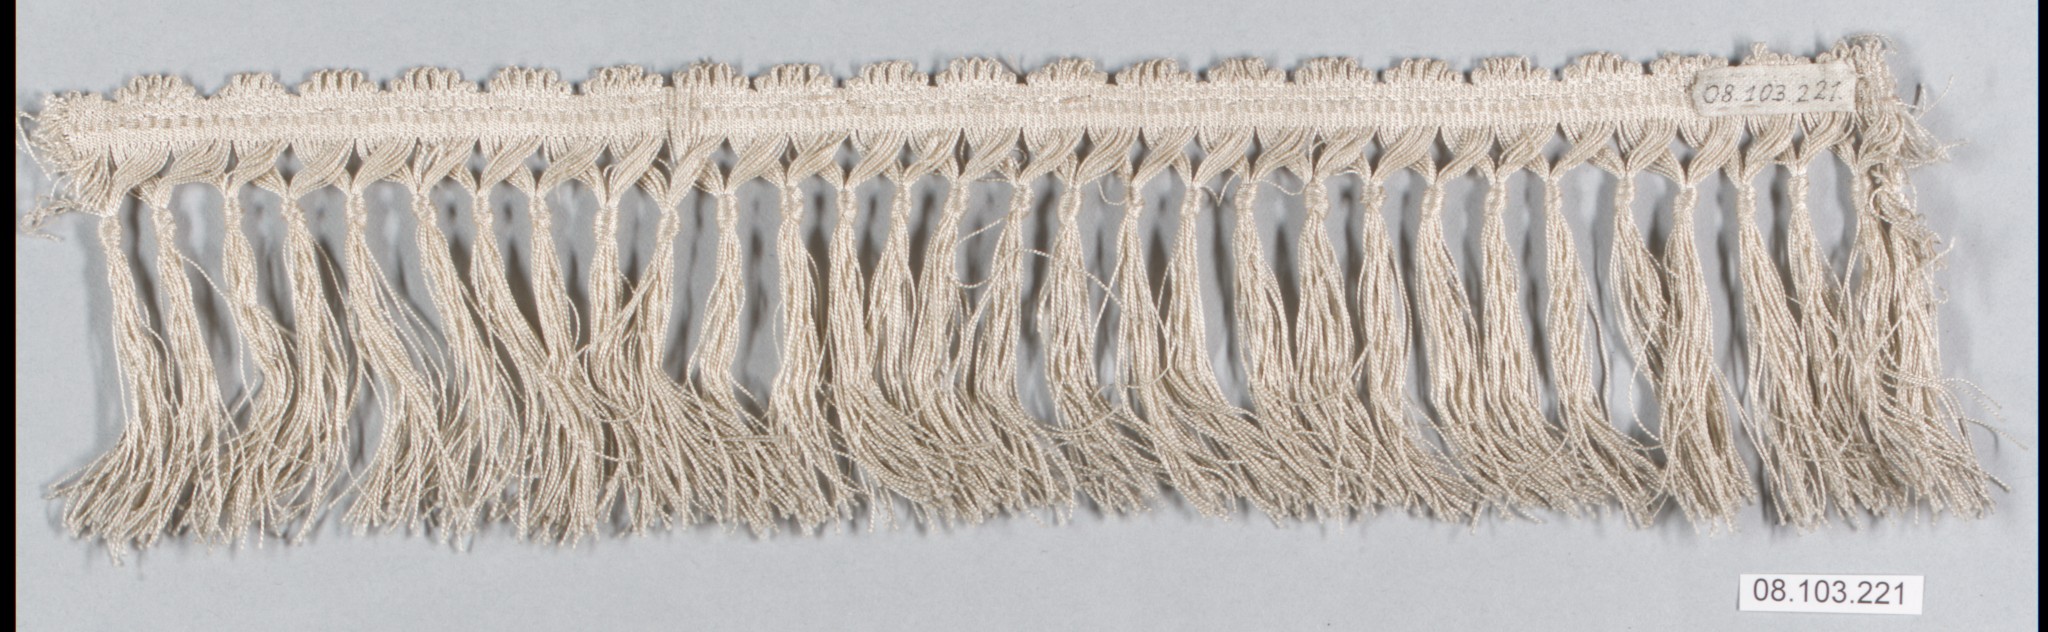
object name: fringe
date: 1801-1900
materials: silk